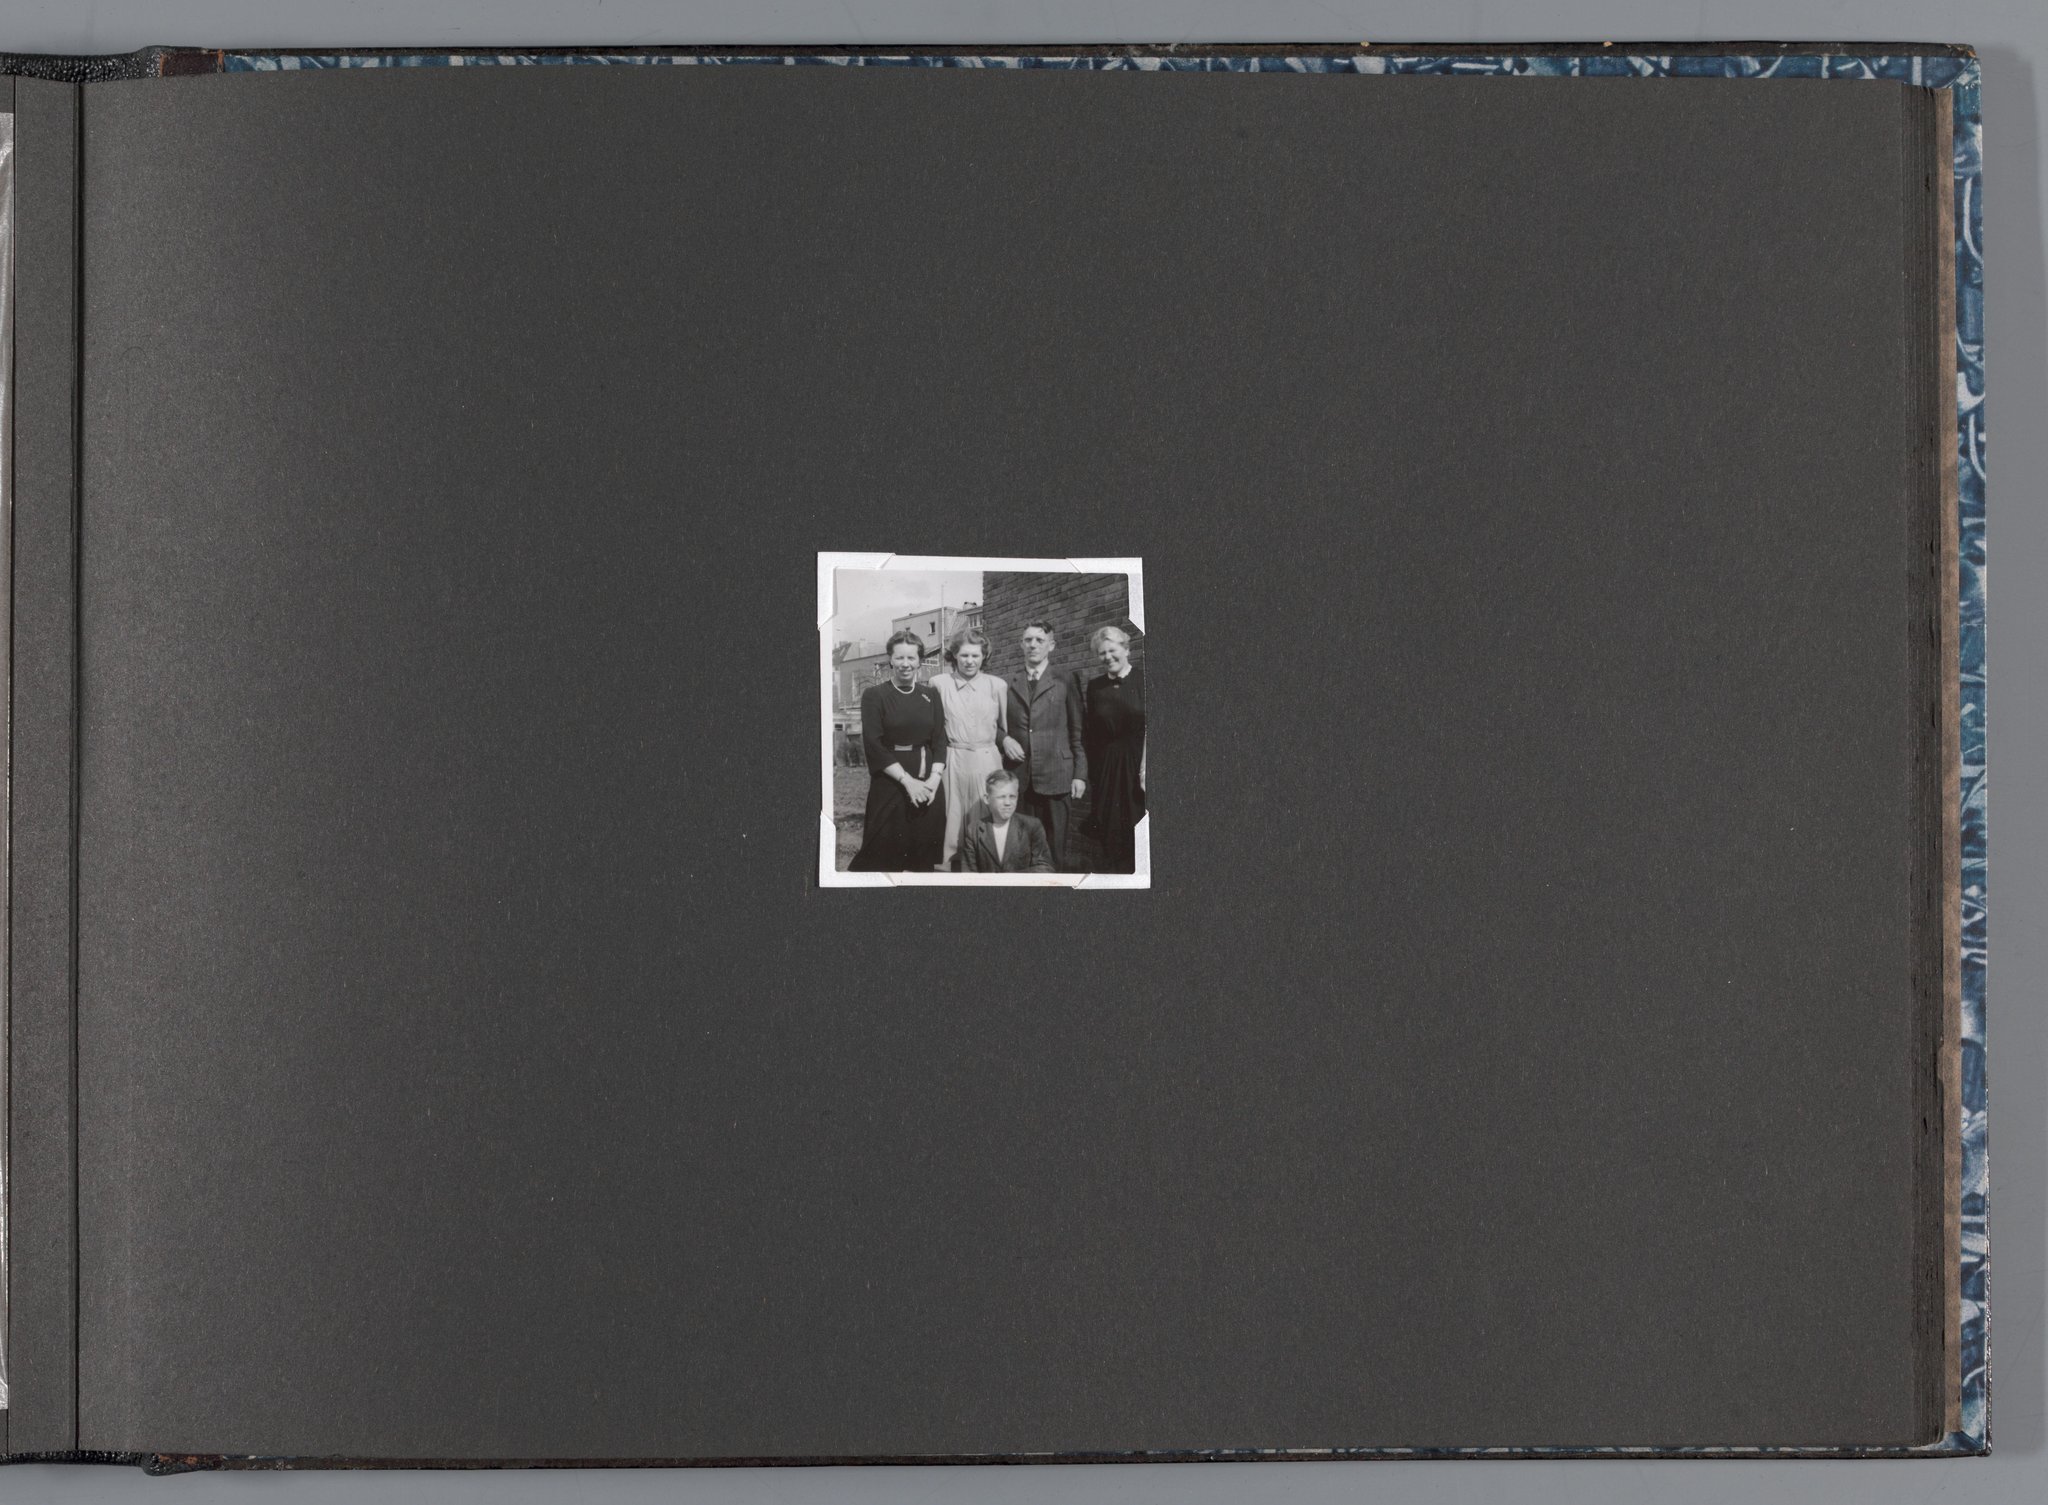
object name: photograph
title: Familie Vonk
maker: Anonymous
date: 1947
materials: cardboard, photographic support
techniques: gelatin silver print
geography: netherlands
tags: jet vonk, r.h. vonk, family life at home, netherlands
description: Albumblad met een portret van het gezin Vonk, met een onbekende vrouw, ca. 1947. Onderdeel van het familiealbum van Jet Vonk uit Celebes.